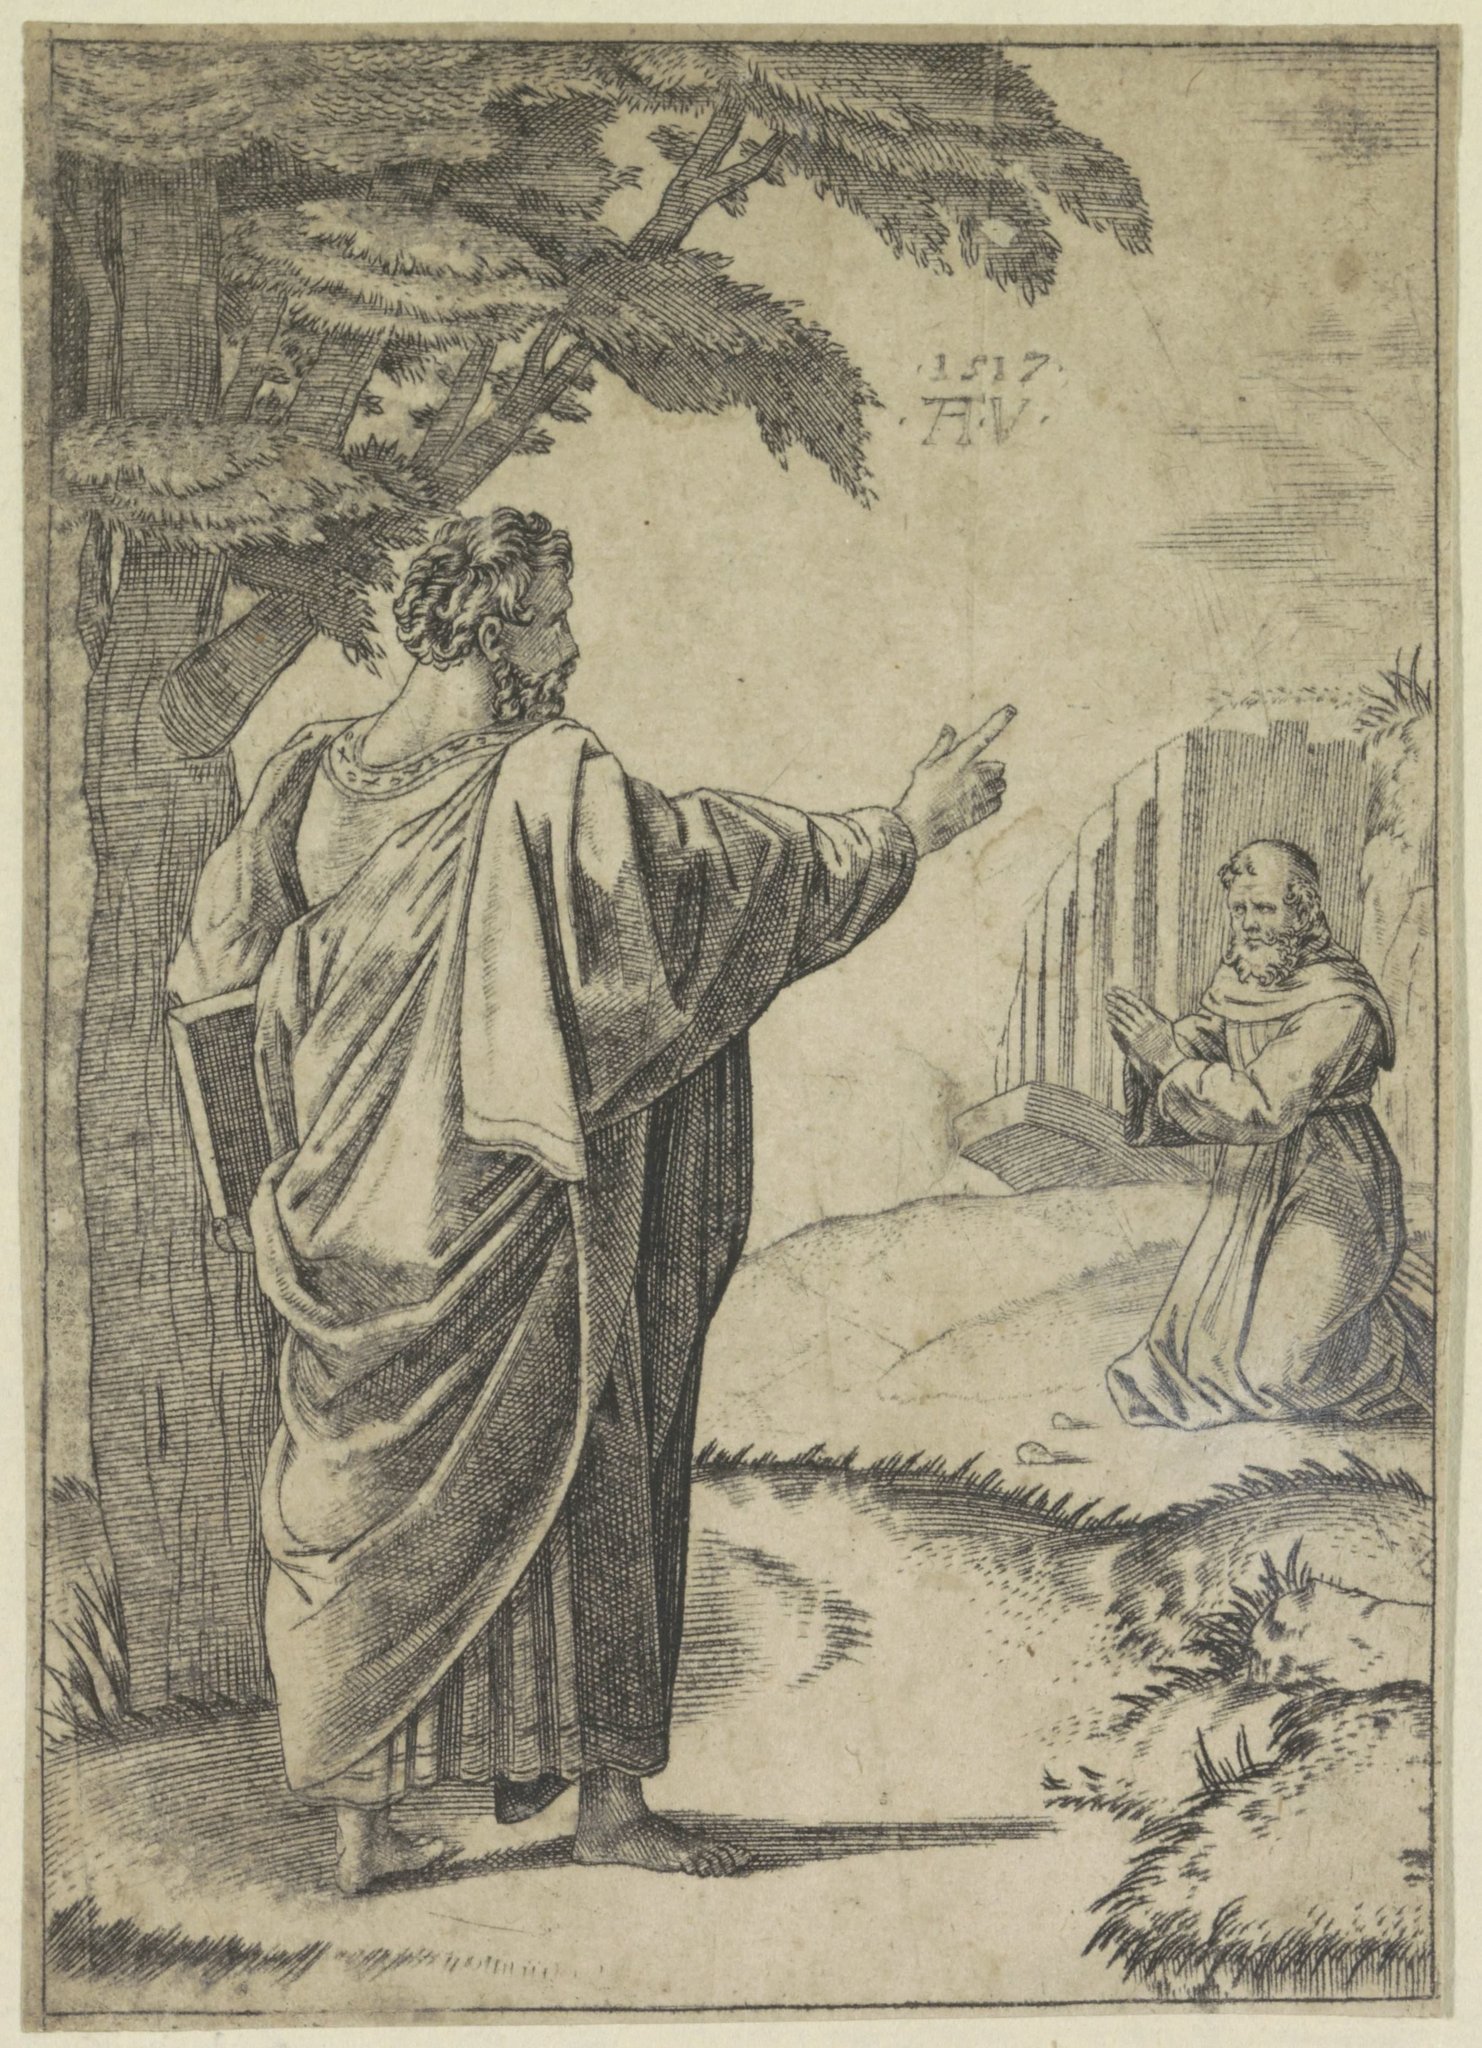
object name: print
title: De heilige Paulus en een Franciscaner monnik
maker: agostino veneziano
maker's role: draughtsman, painter, print maker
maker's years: 1490-1536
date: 1517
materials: paper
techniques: engraving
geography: italy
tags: monk(s), friar(s), one person praying, the apostle paul of tarsus; possible attributes: book, scroll, sword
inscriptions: collector's mark: Lugt 12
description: De heilige Paulus staat links met een boek onder de arm. Links naast hem een boom. Rechts zit een Franciscaner monnik geknield in gebed.